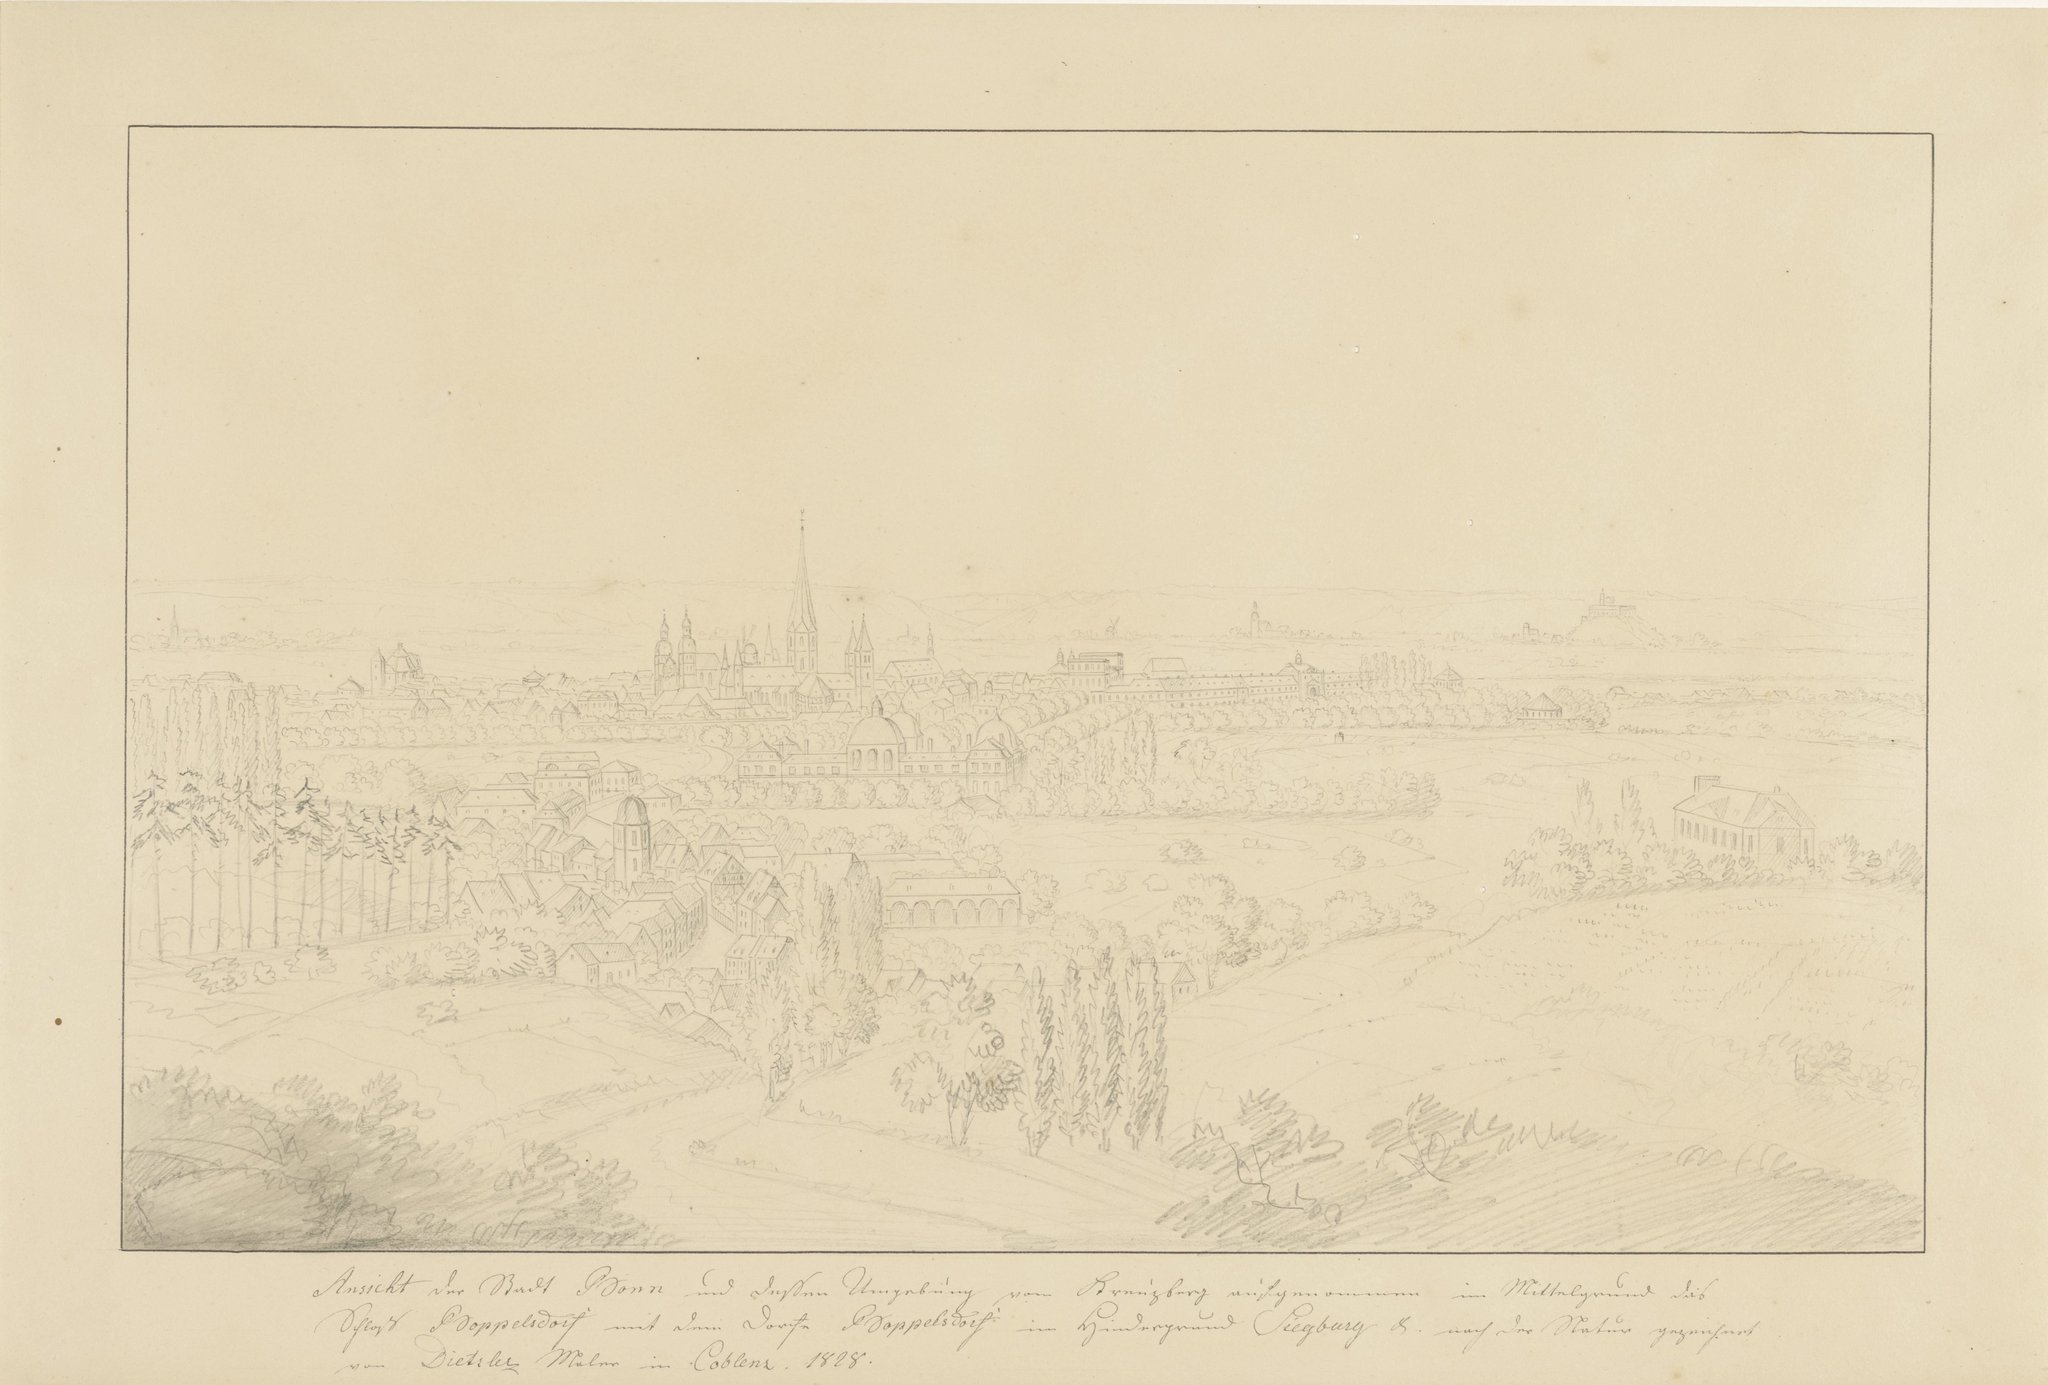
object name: drawing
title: Gezicht op Bonn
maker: jakob dietzler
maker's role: draughtsman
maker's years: 1789-1855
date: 1828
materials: ink, paper, pencil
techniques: pen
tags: river (+ landscape with figures, staffage), prospect of city, town panorama, silhouette of city (+ city(-scape) with figures, staffage)